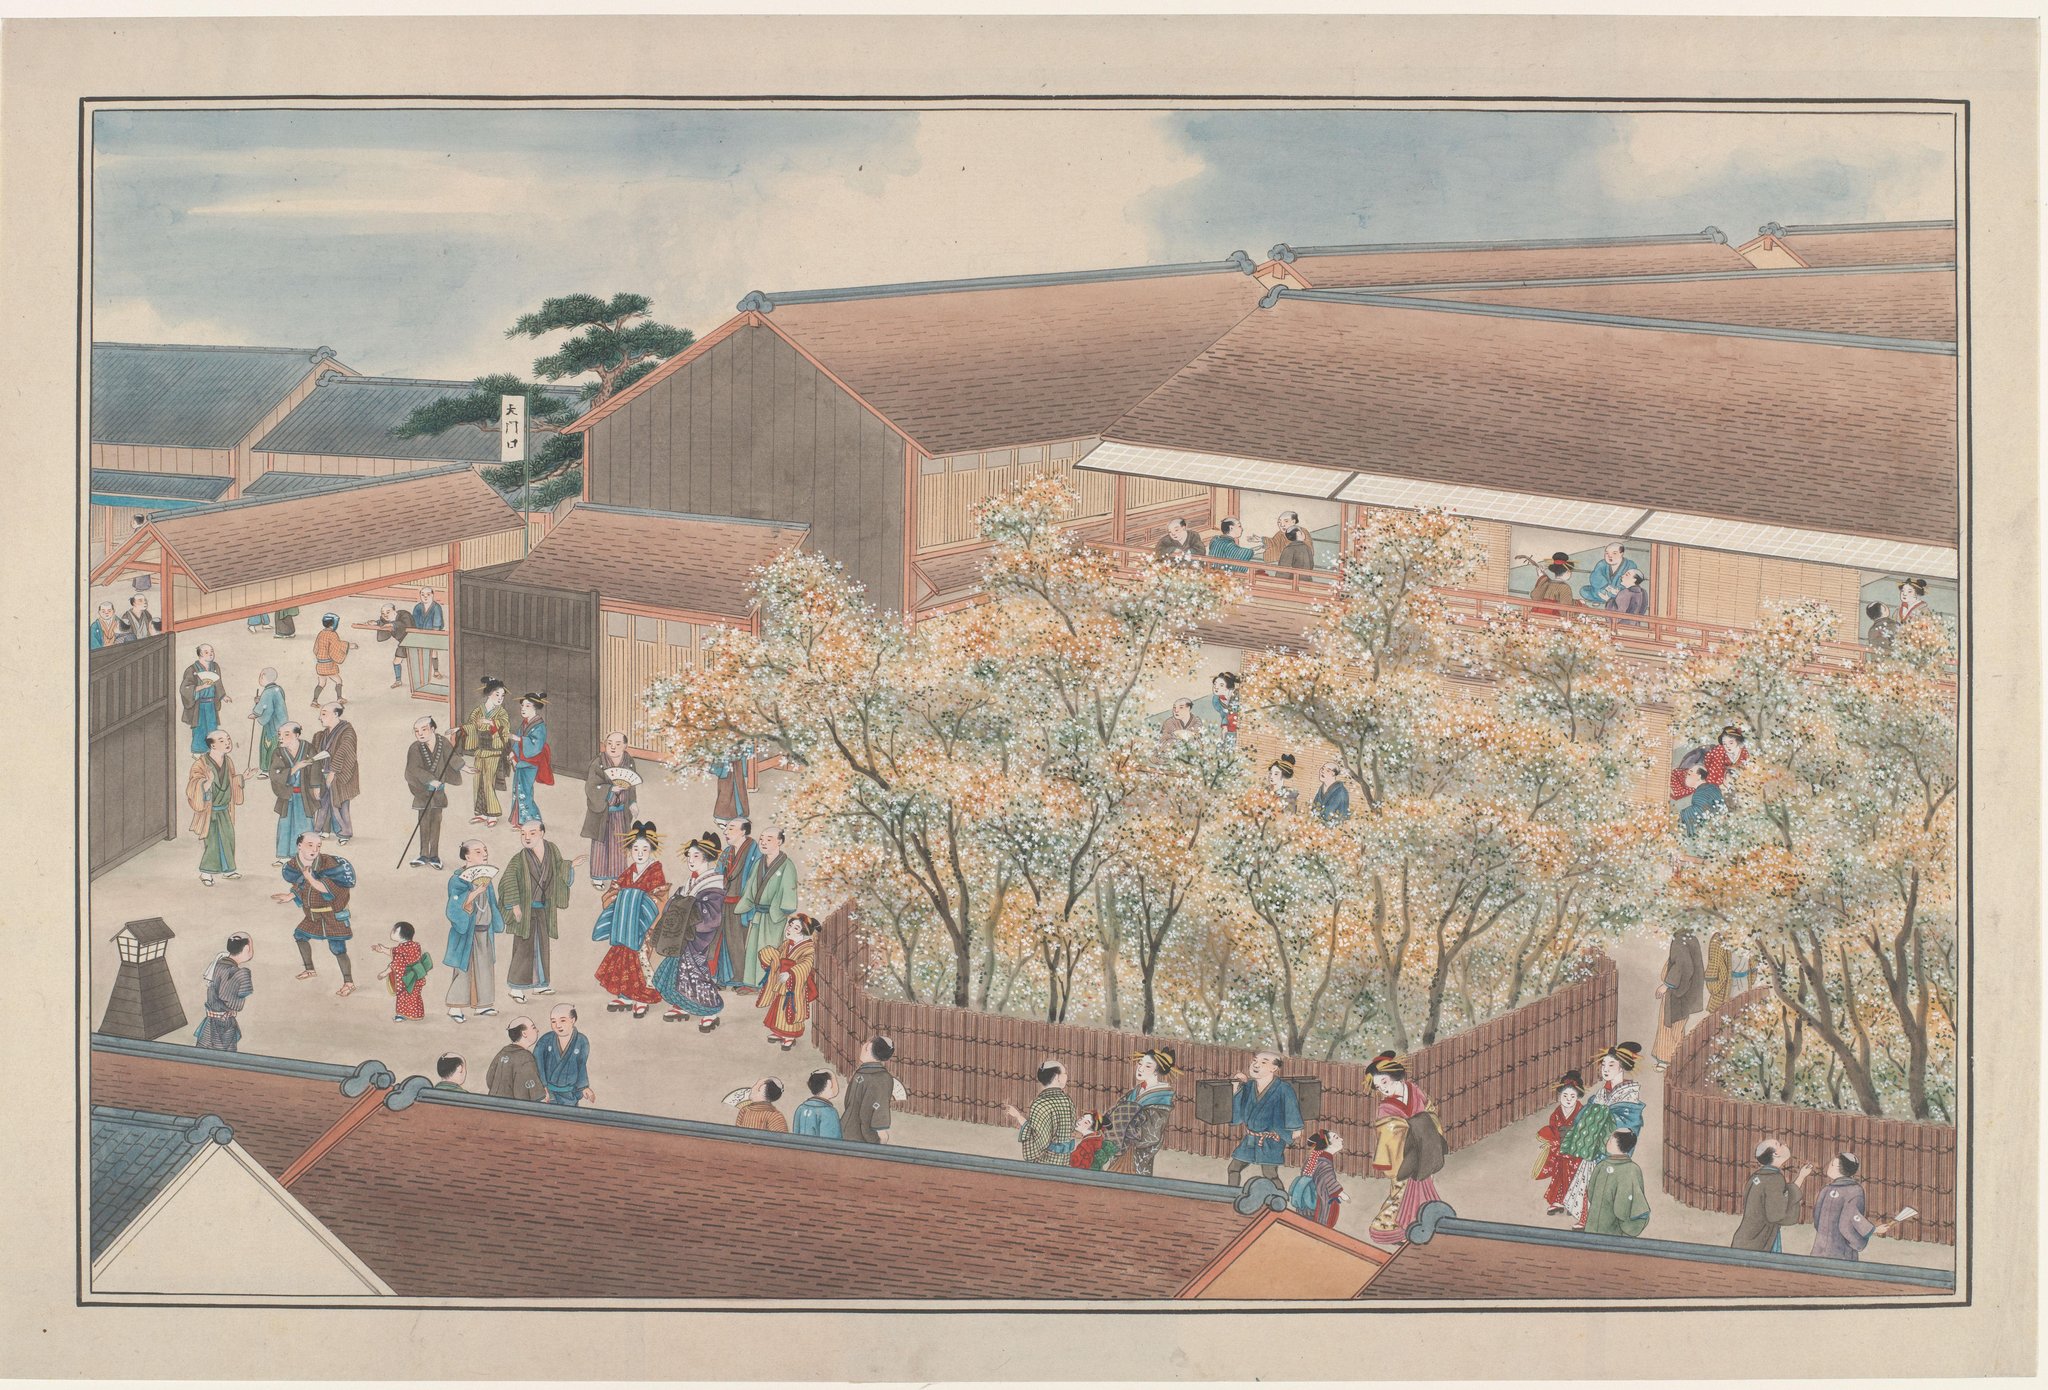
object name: drawing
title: Hoerstraat op Miako in de maand Mei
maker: Anonymous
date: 1800-1900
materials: paper, watercolor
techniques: brush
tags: soliciting in the street ~ prostitution, kyoto